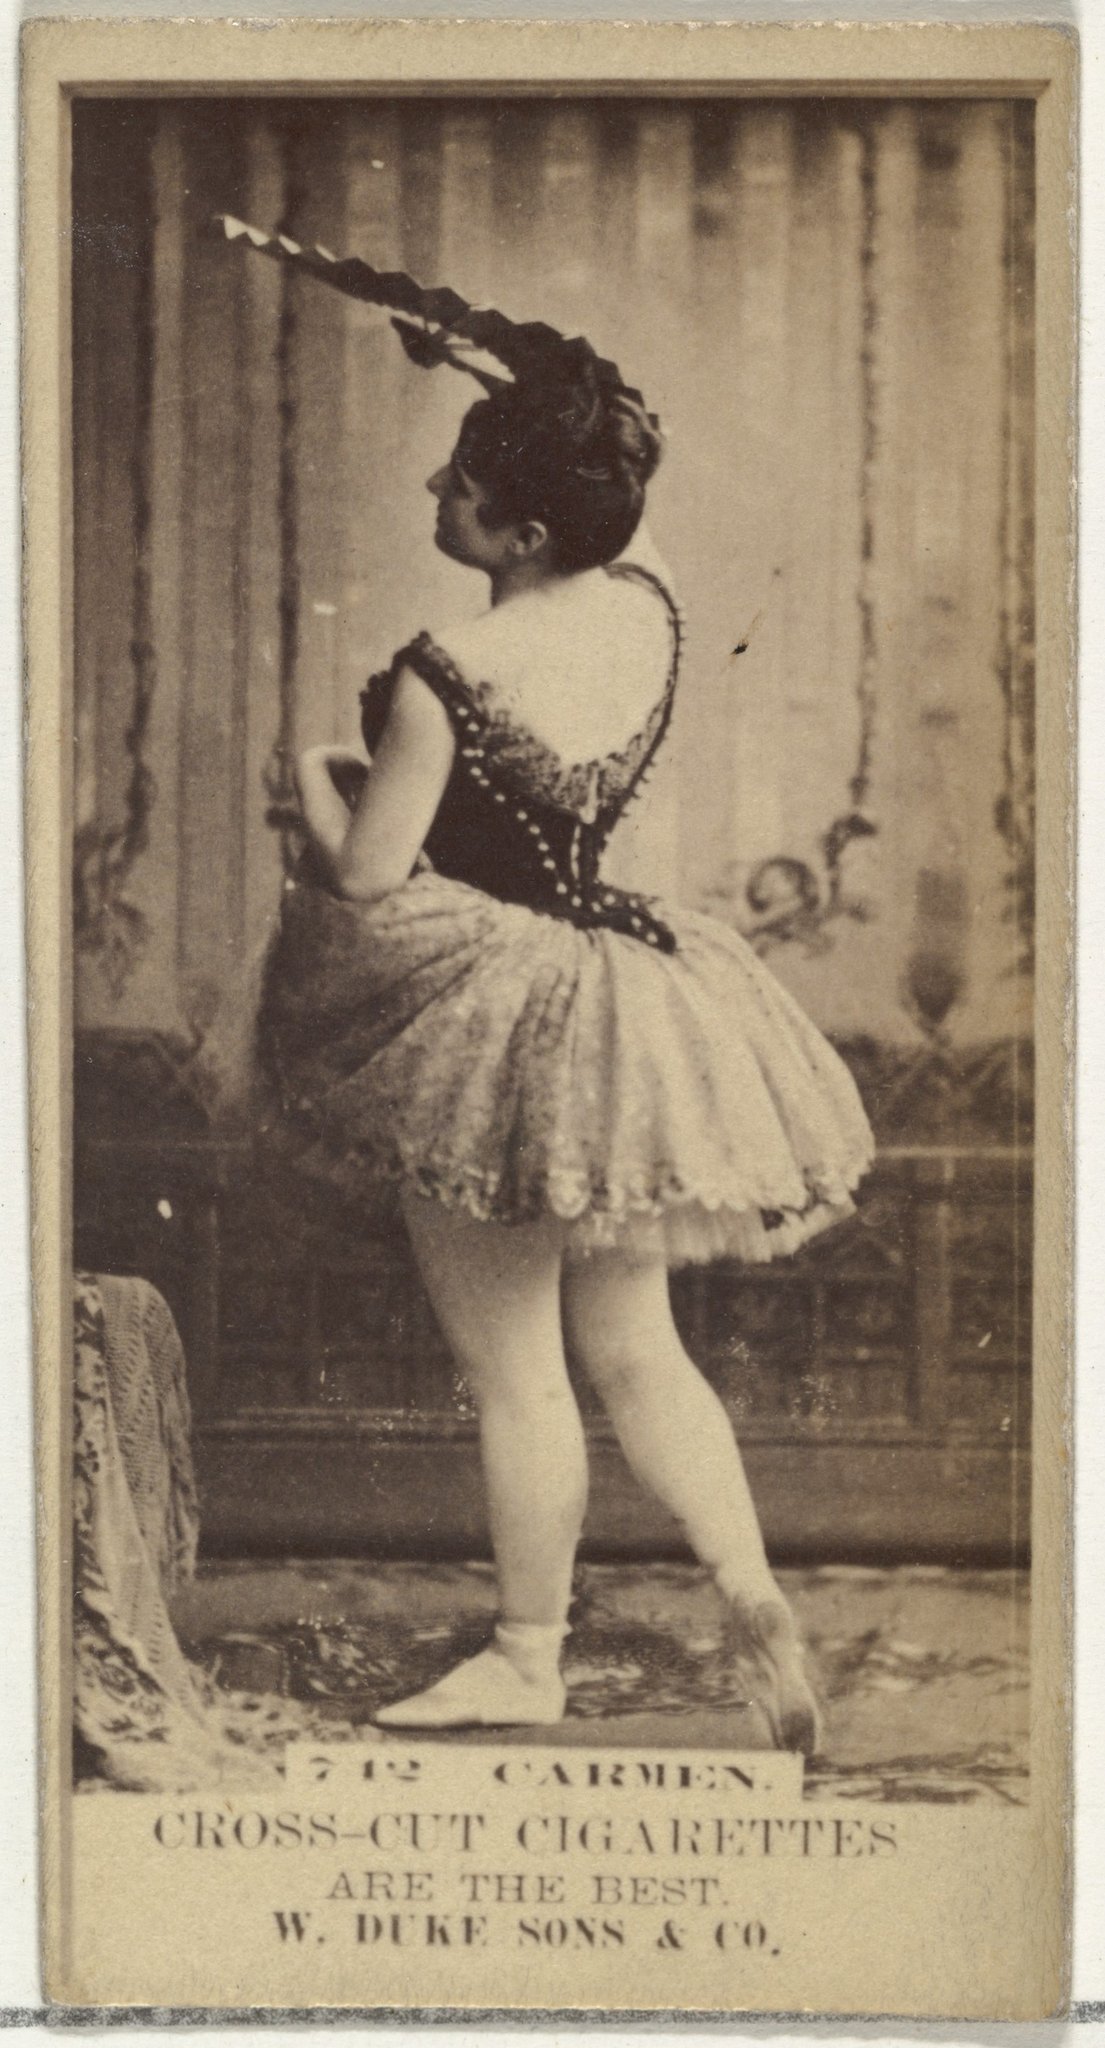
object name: photograph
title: Card Number 712, Carmen, from the Actors and Actresses series (N145-3) issued by Duke Sons & Co. to promote Cross Cut Cigarettes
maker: w. duke, sons & co.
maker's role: publisher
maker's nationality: american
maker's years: 1870-1920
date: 1880-1889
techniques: albumen silver print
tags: women,actresses